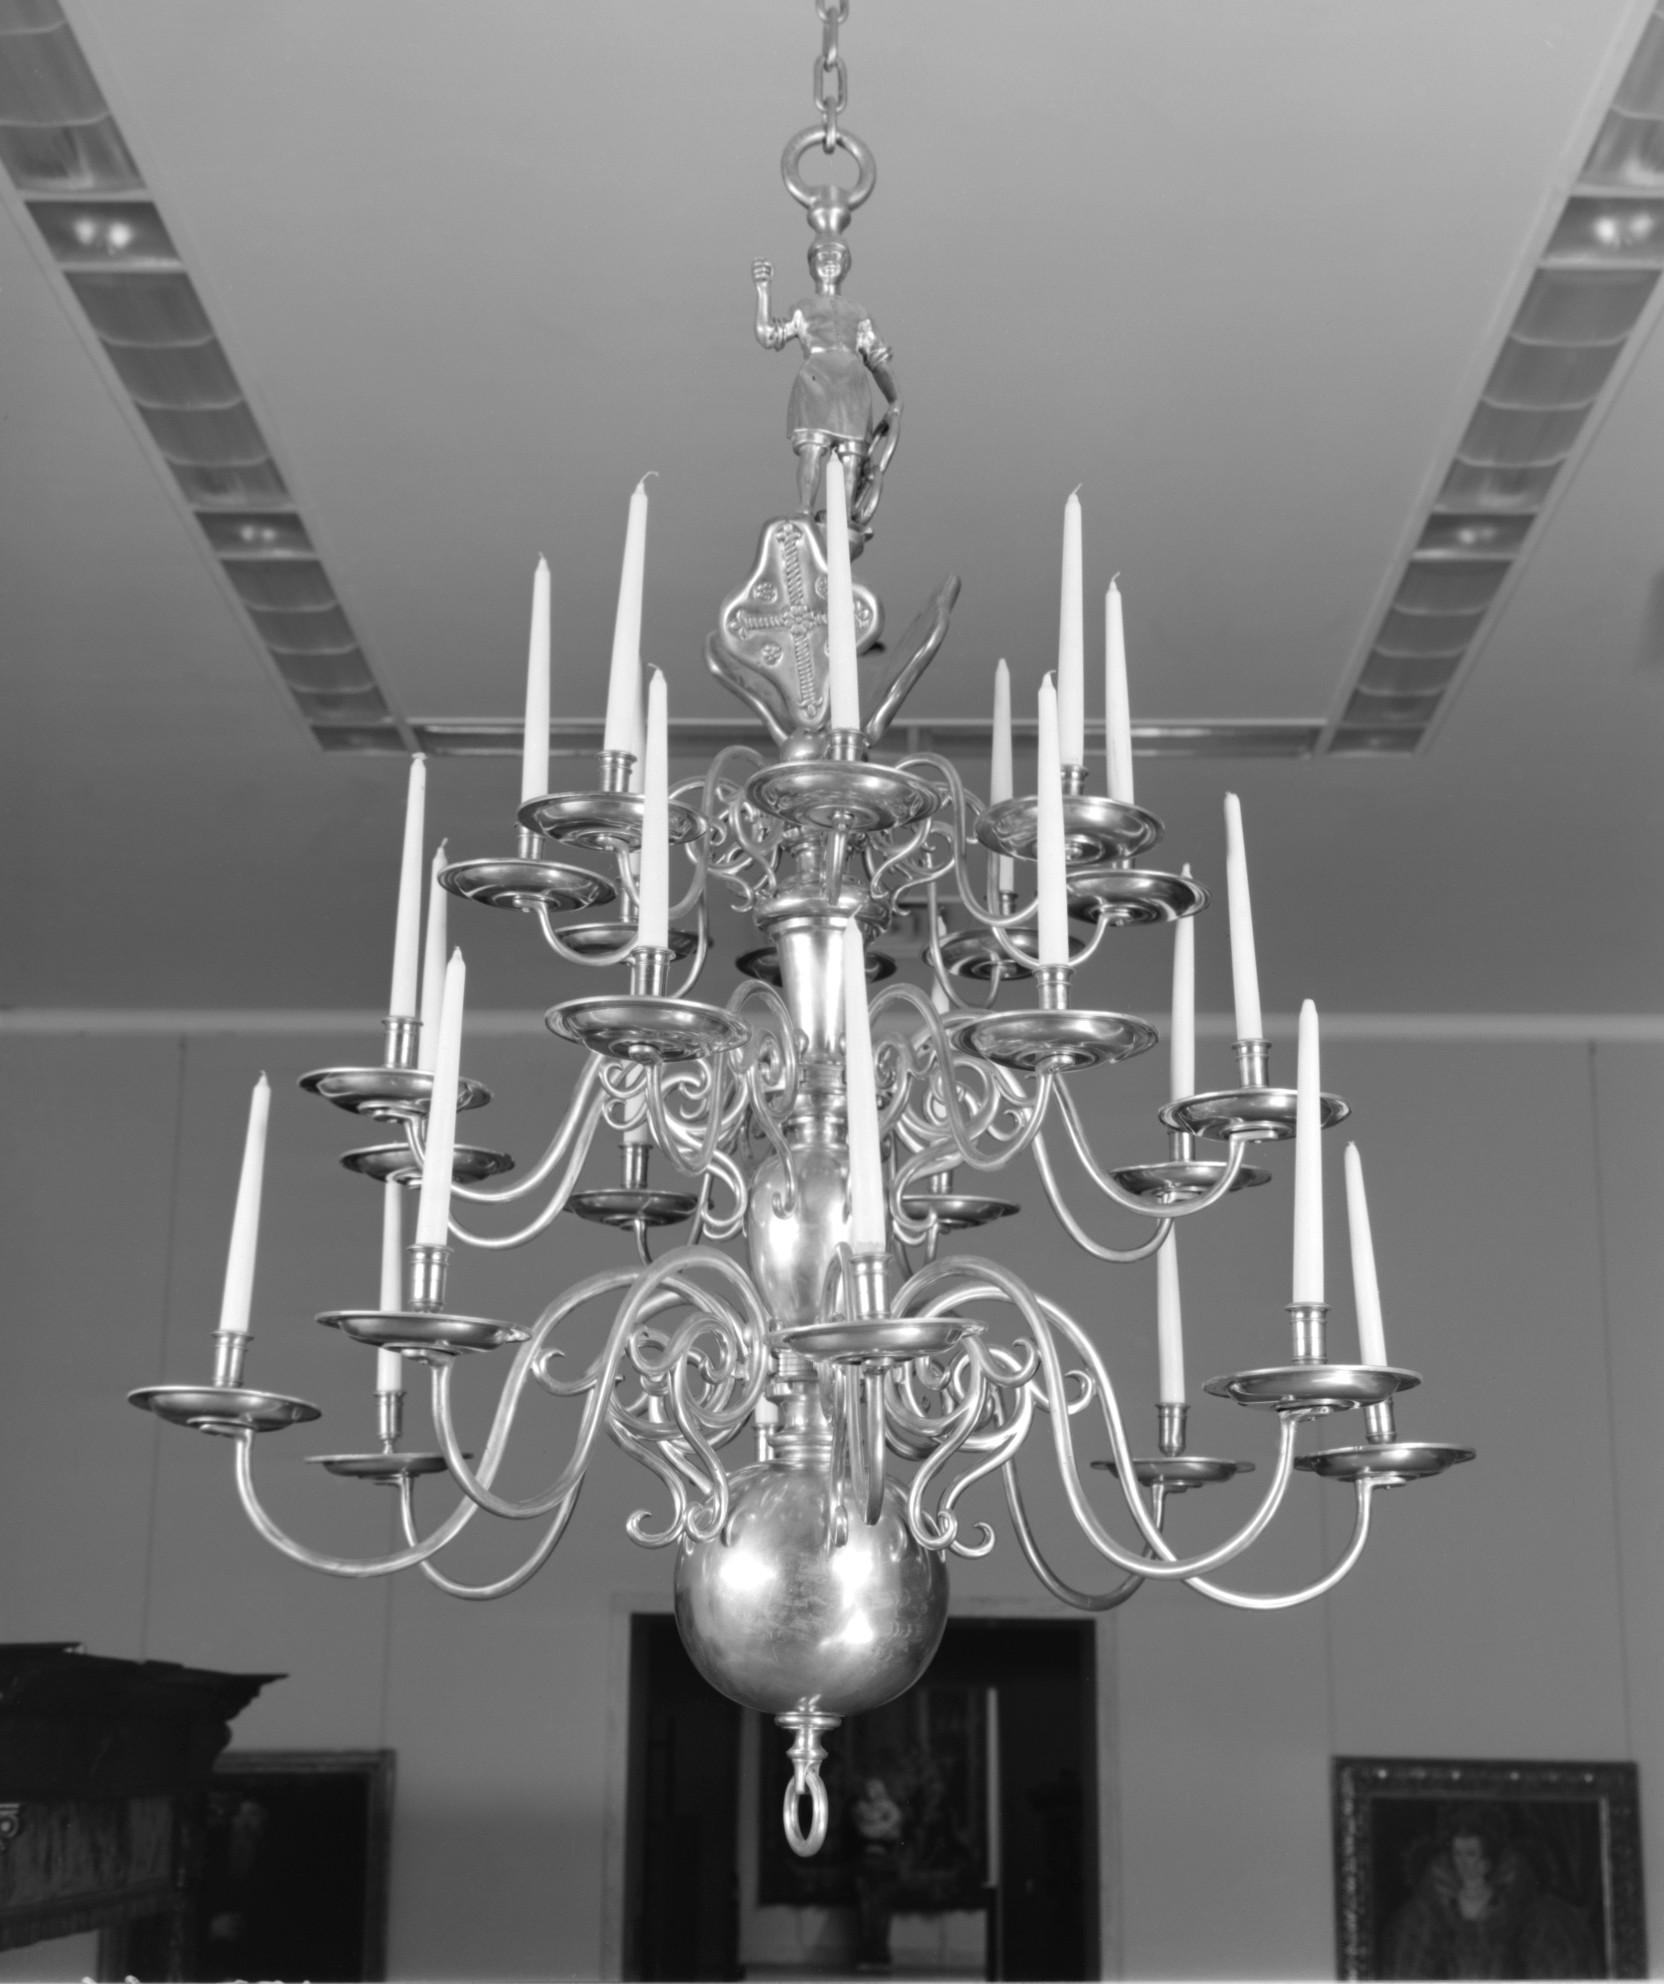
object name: chandelier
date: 1651-1700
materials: brass